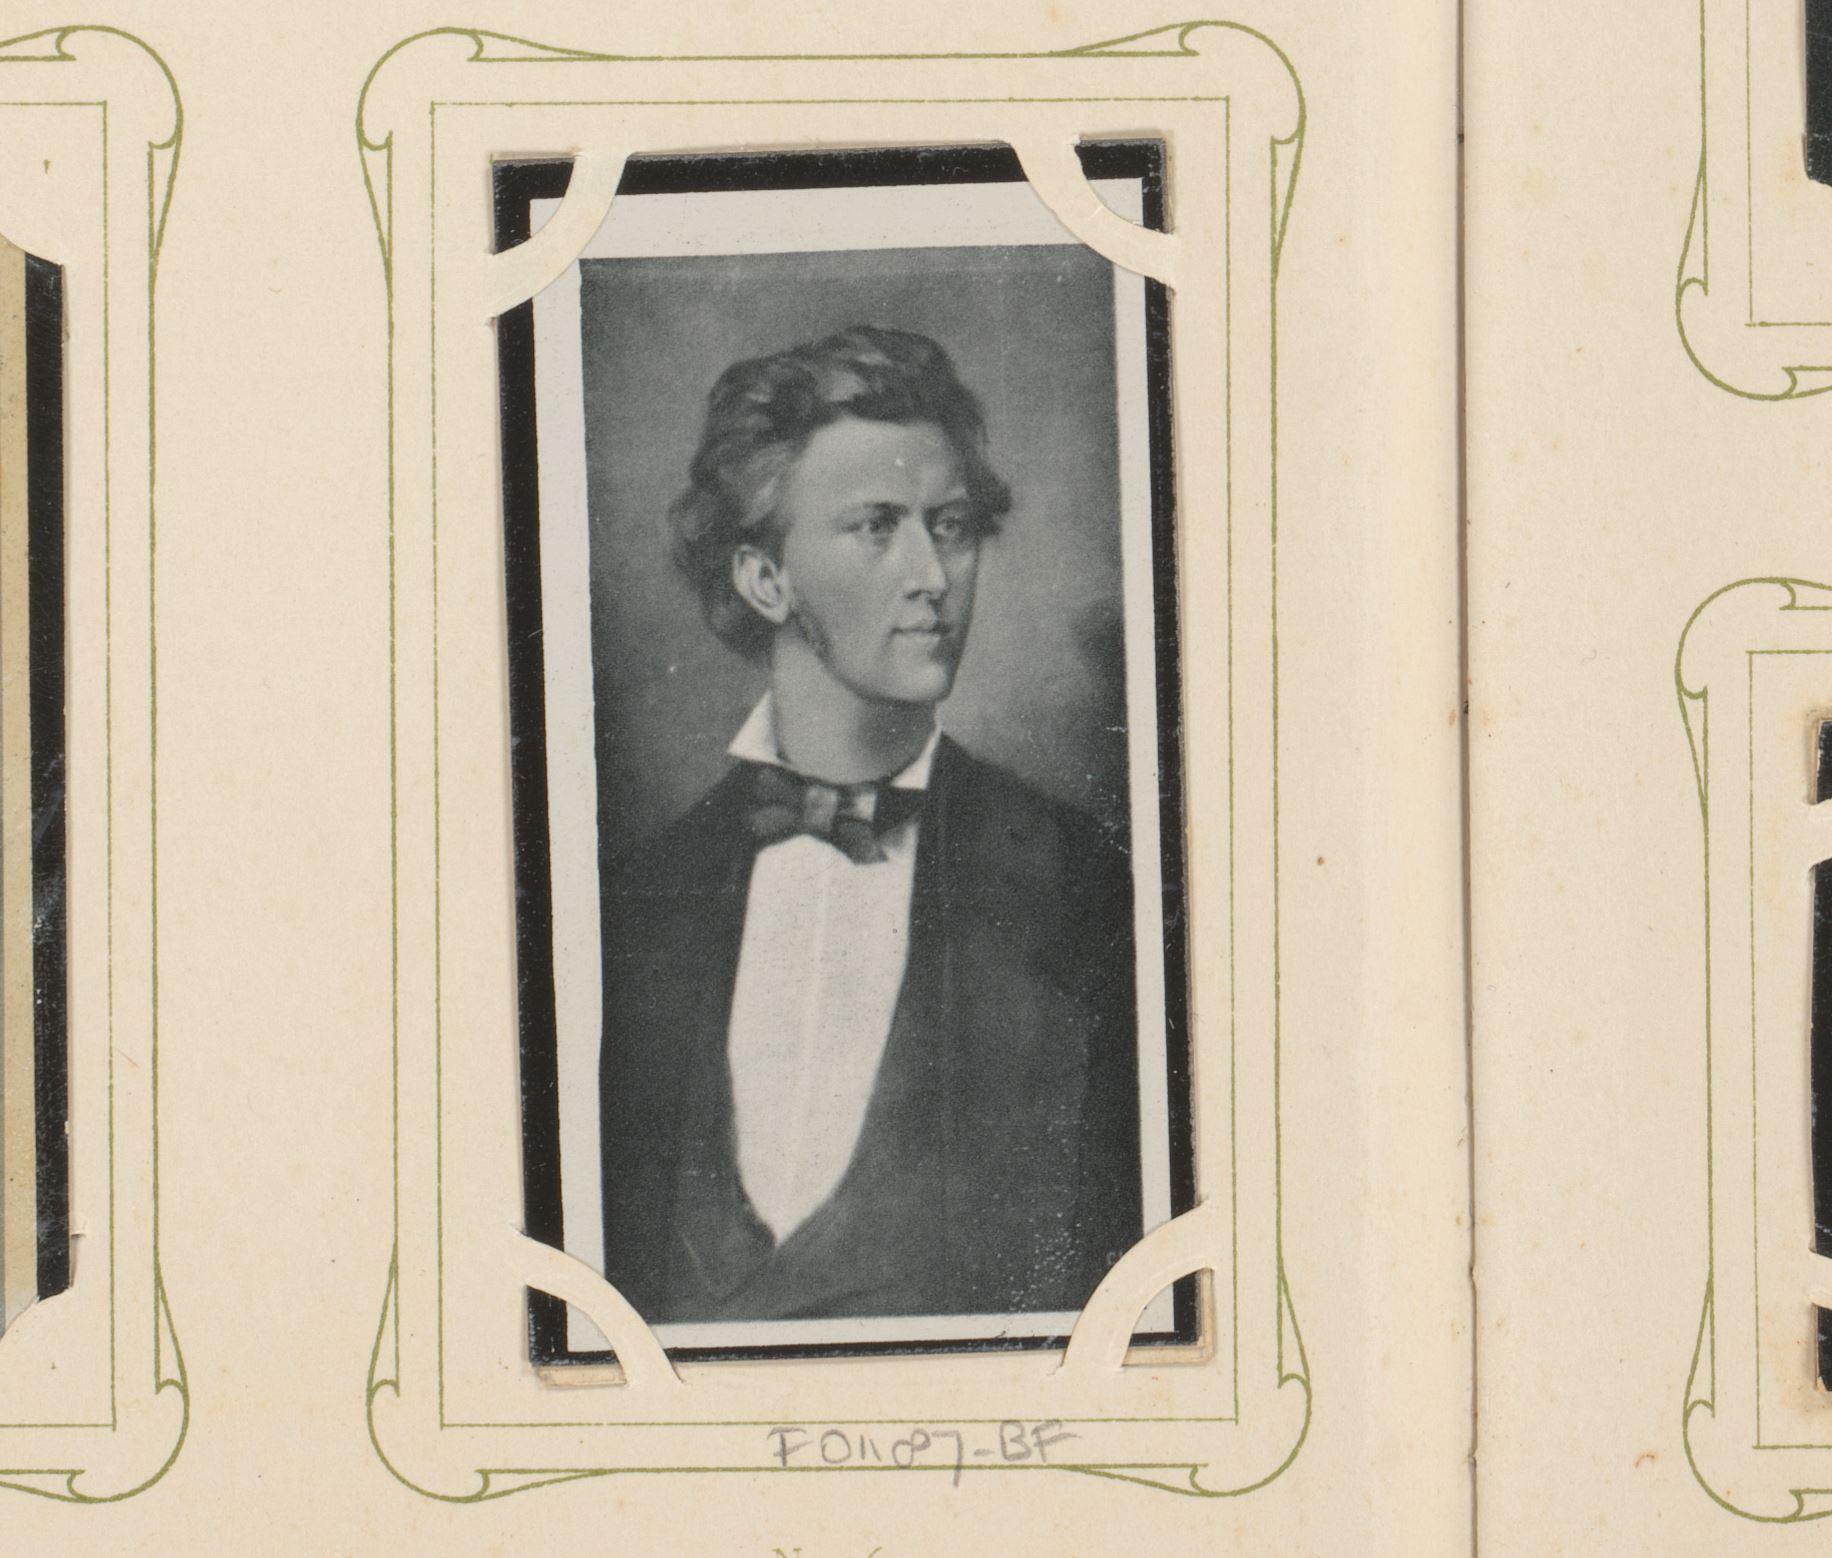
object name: reproduction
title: Reproductie van een geschilderd portret van Richard Wagner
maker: Anonymous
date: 1905-1906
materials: paper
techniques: photograph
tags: richard wagner, historical persons, portrait of composer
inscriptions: inscription: ‘No. 6./ Richard Wagner.’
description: Deze prent maakt deel uit van een album.